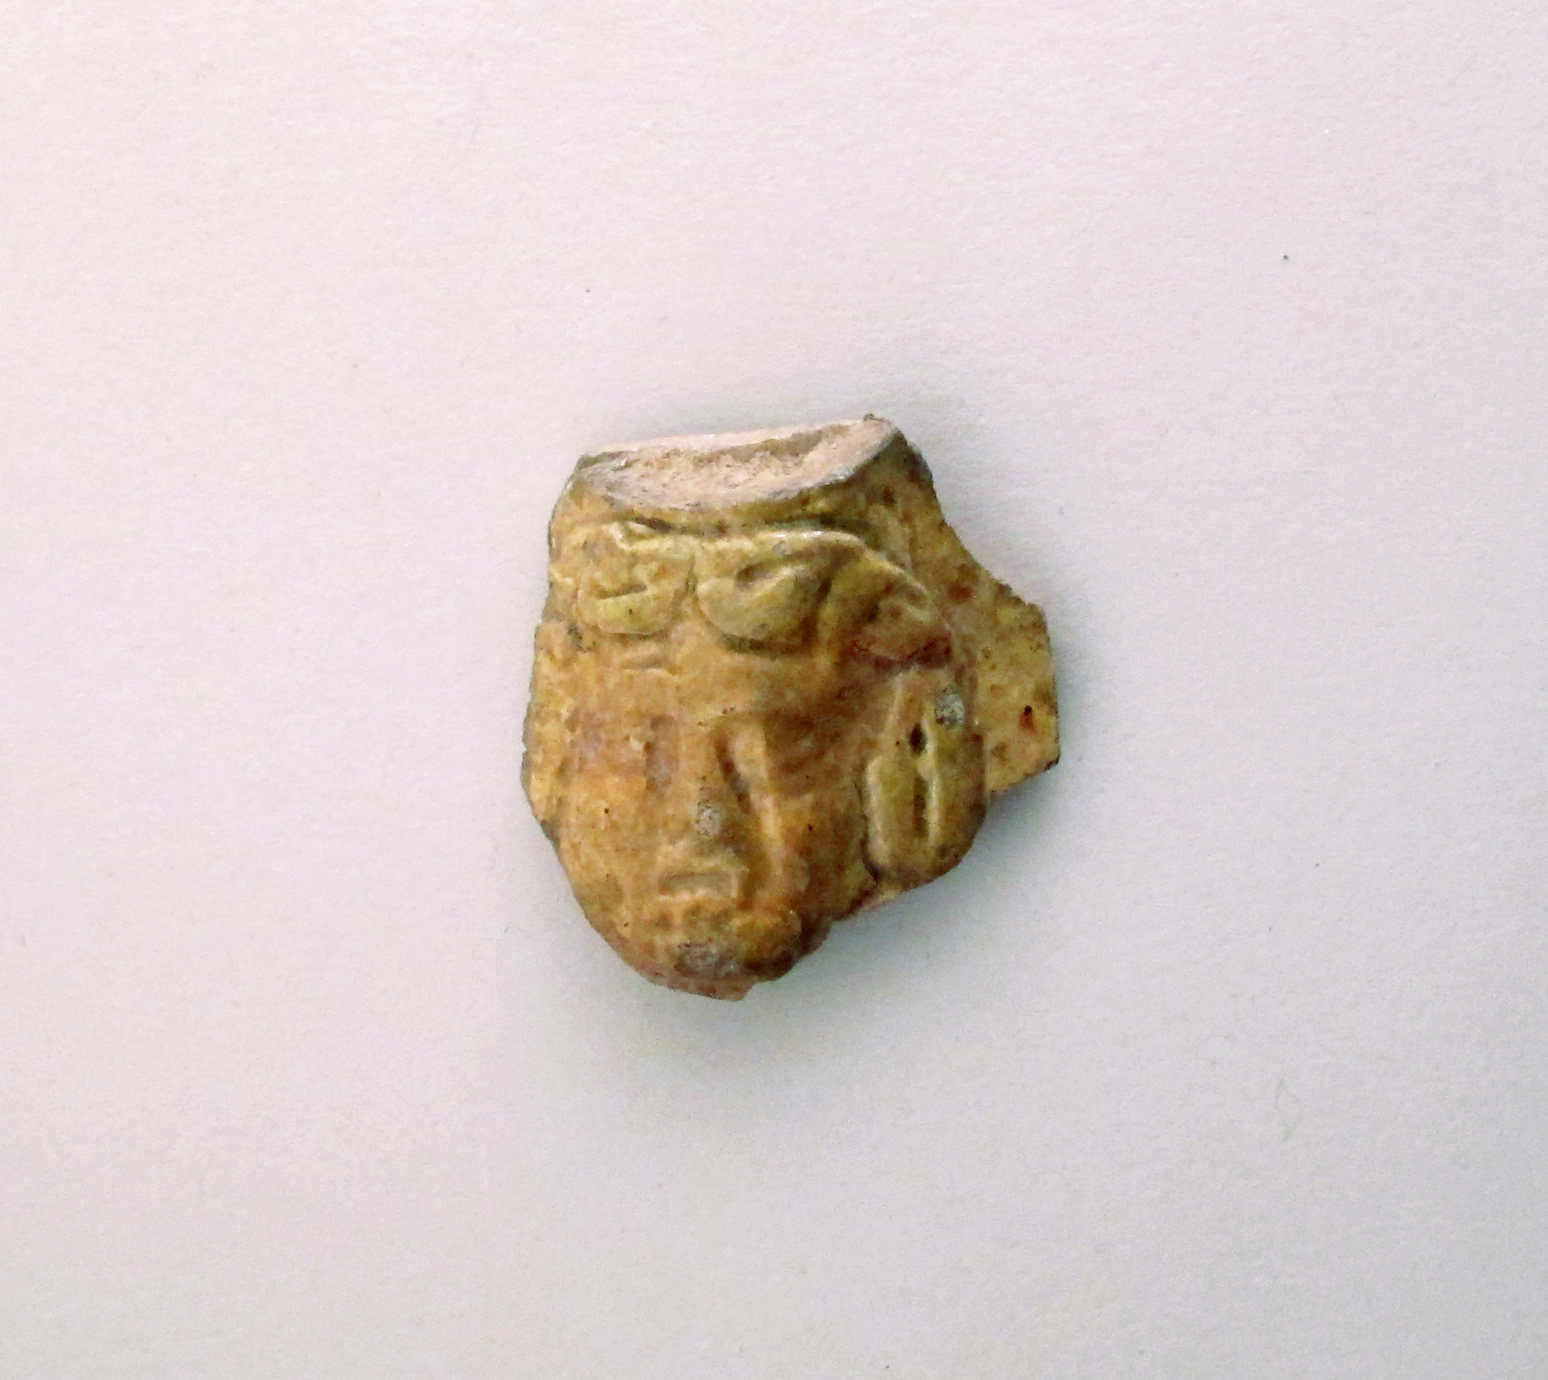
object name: vase fragment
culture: roman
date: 670 BCE-330 CE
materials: terracotta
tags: faces